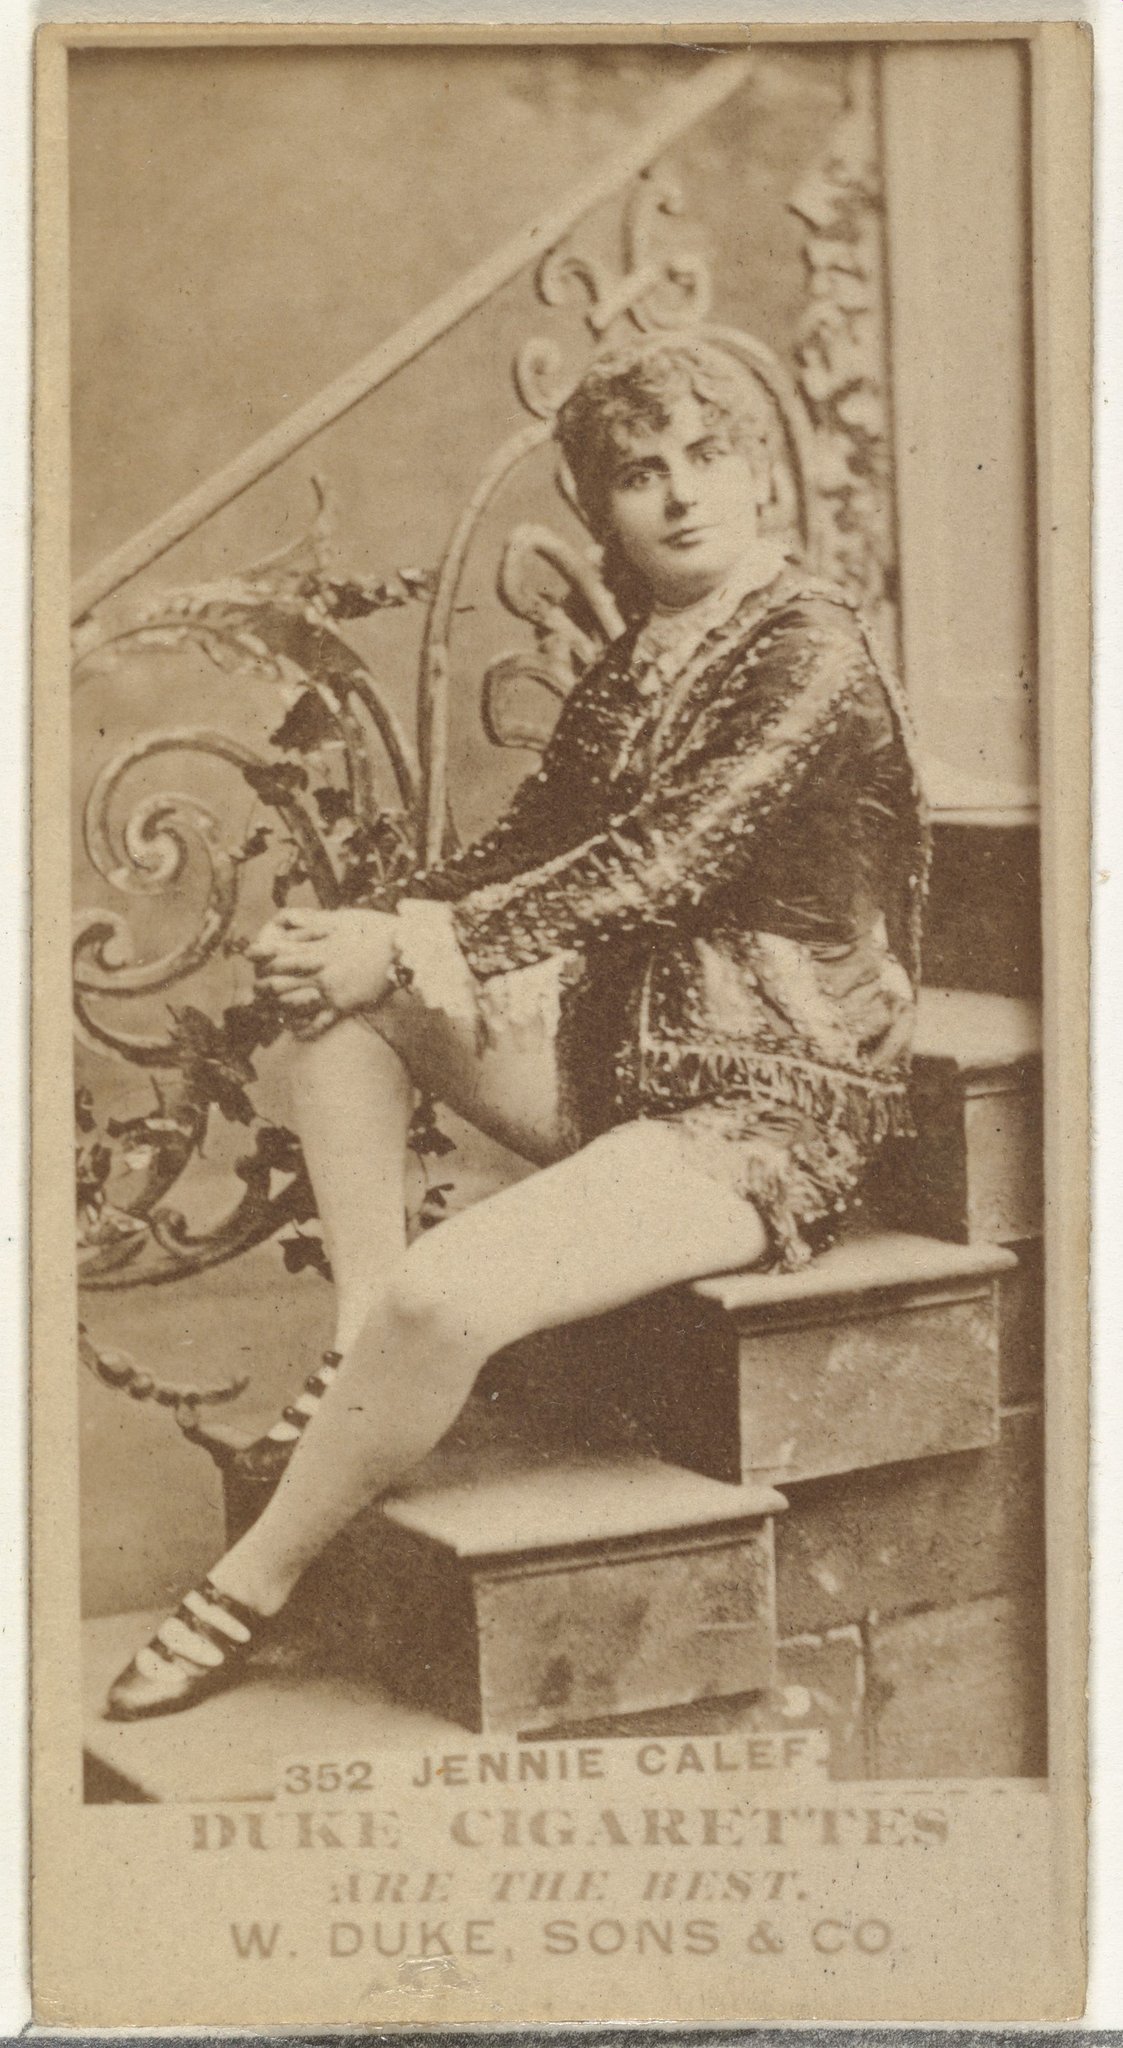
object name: photograph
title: Card Number 352, Jennie Calef, from the Actors and Actresses series (N145-7) issued by Duke Sons & Co. to promote Duke Cigarettes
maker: w. duke, sons & co.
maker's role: publisher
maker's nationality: american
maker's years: 1870-1920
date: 1880-1889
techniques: albumen silver print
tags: portraits,women,actresses